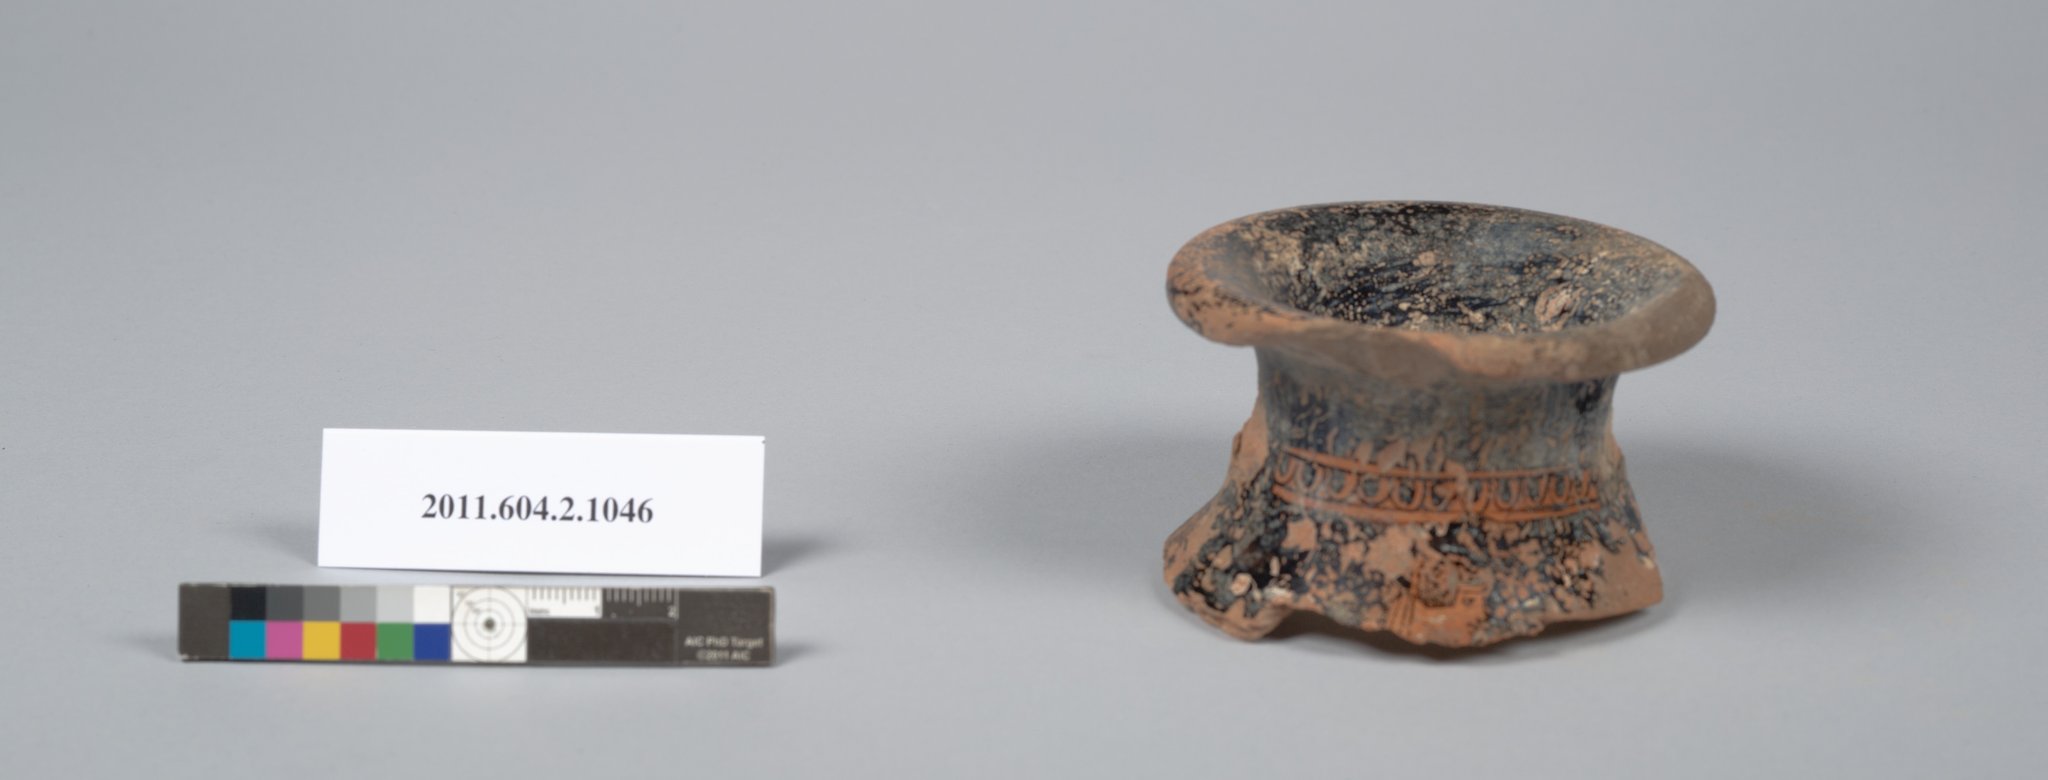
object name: pelike fragment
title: Terracotta fragment of a pelike (jar)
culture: greek, attic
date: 475-451 BCE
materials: terracotta